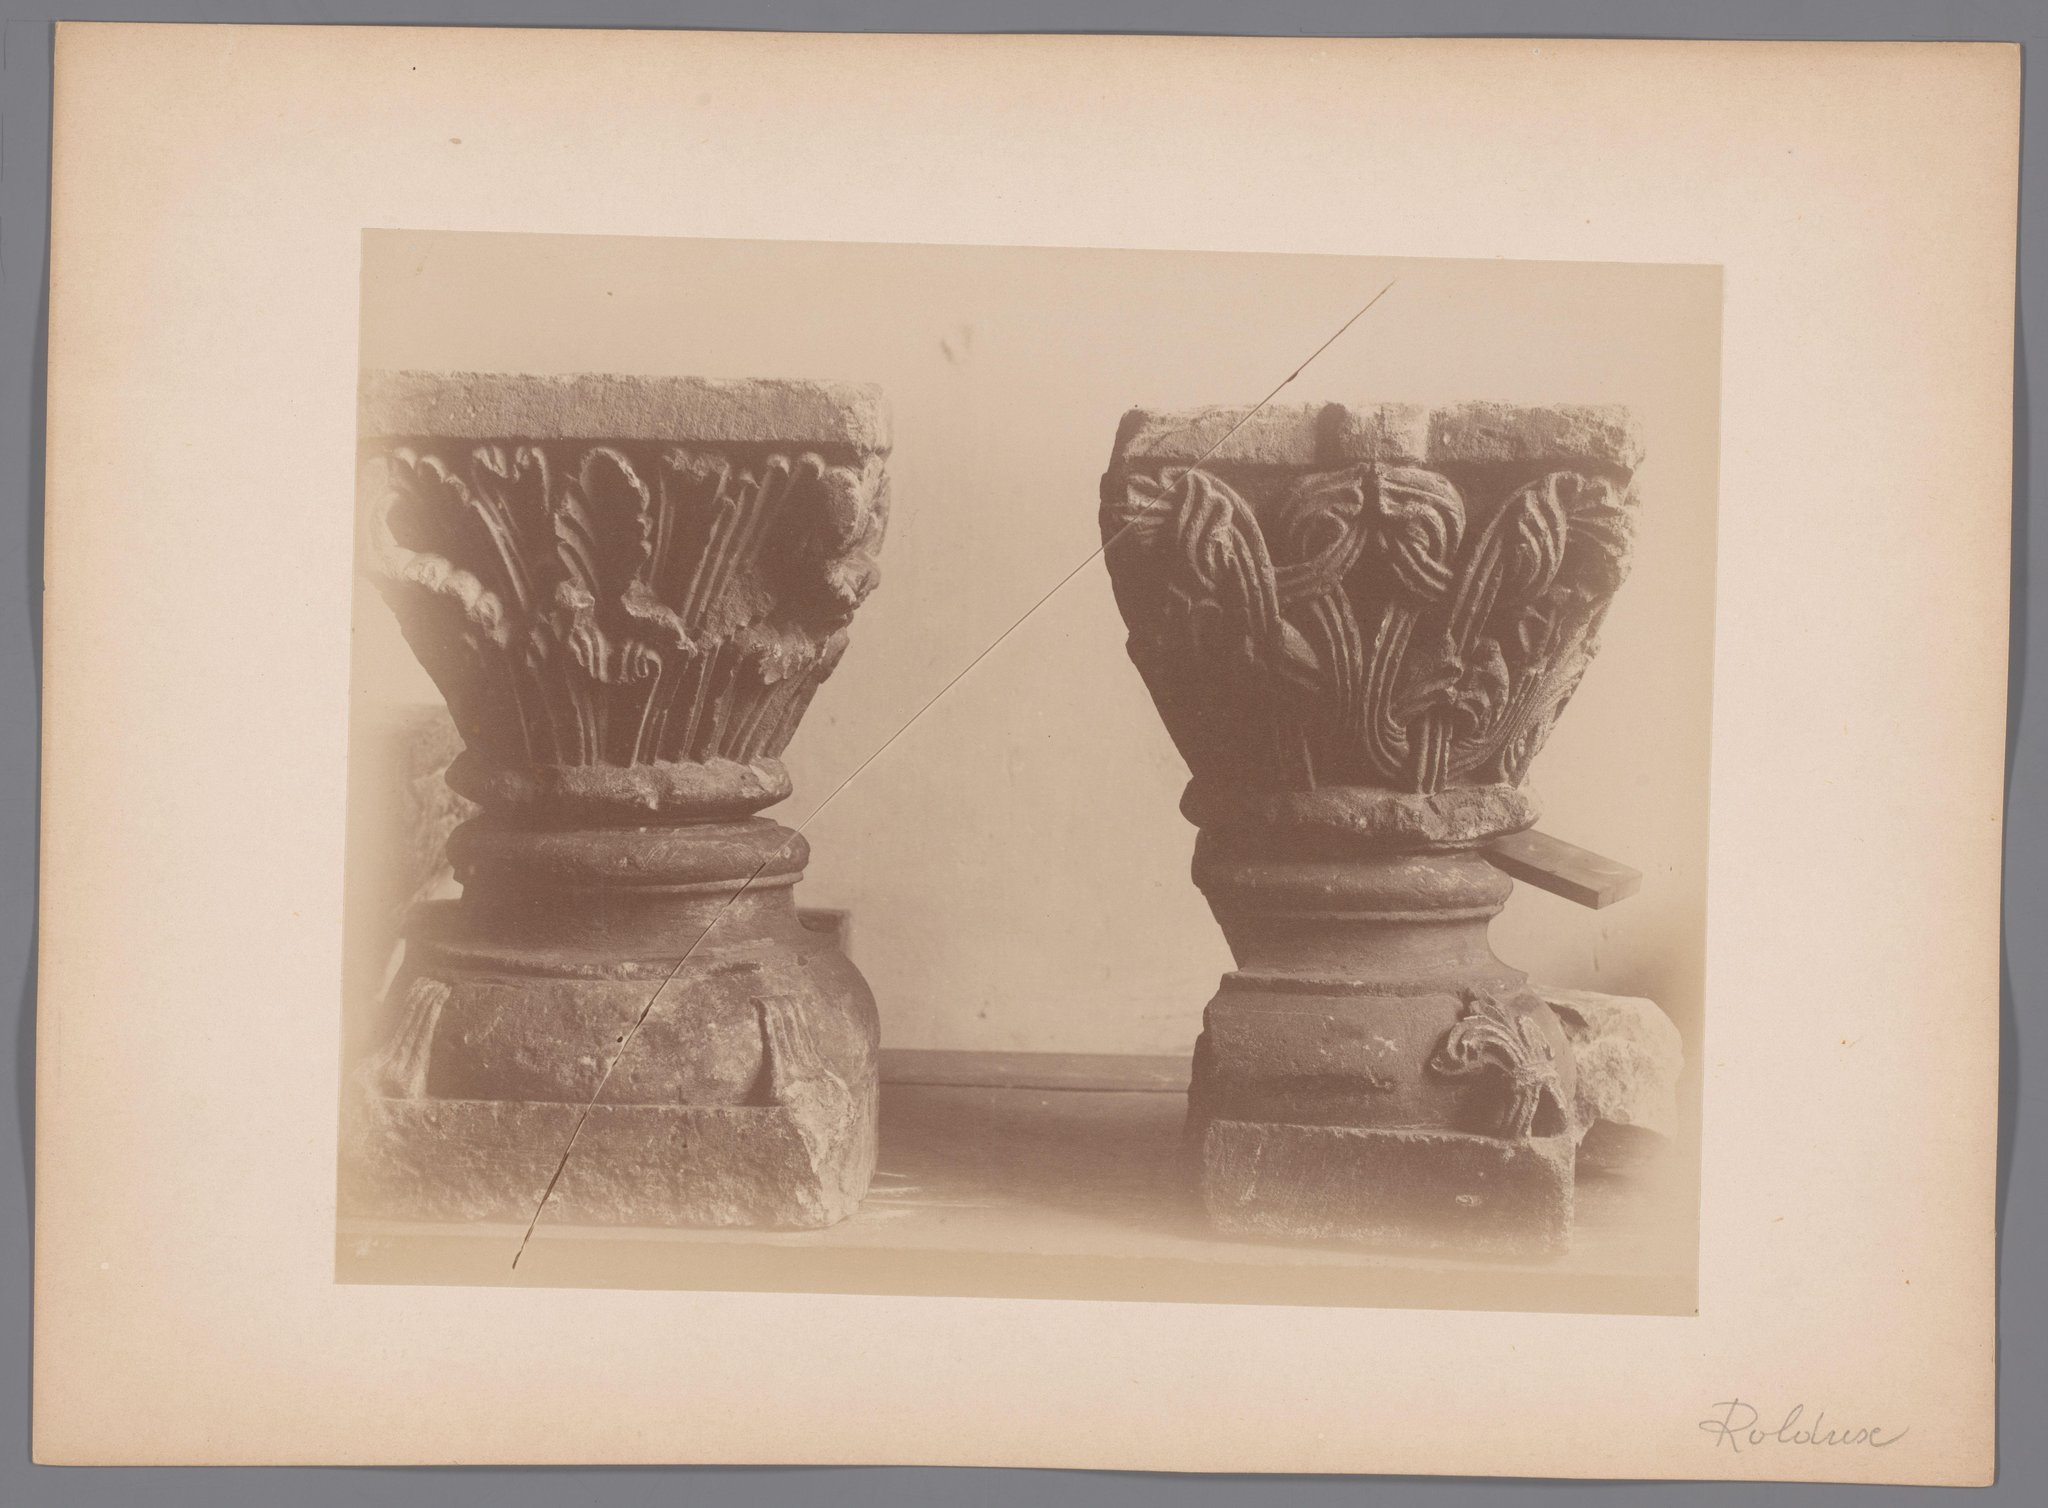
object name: photograph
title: Basementen, gevonden bij opgravingen op de binnenplaats van het seminarie te Rolduc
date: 1890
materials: cardboard, photographic support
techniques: albumen print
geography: rolduc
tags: base (~ column, pillar)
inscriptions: annotation: ‘Rolduc’, annotation: ‘Basementen en kapiteelen gevonden bij het doen van opgravingen op de binnenplaats van het Instituut te Rolduc oct 1890’